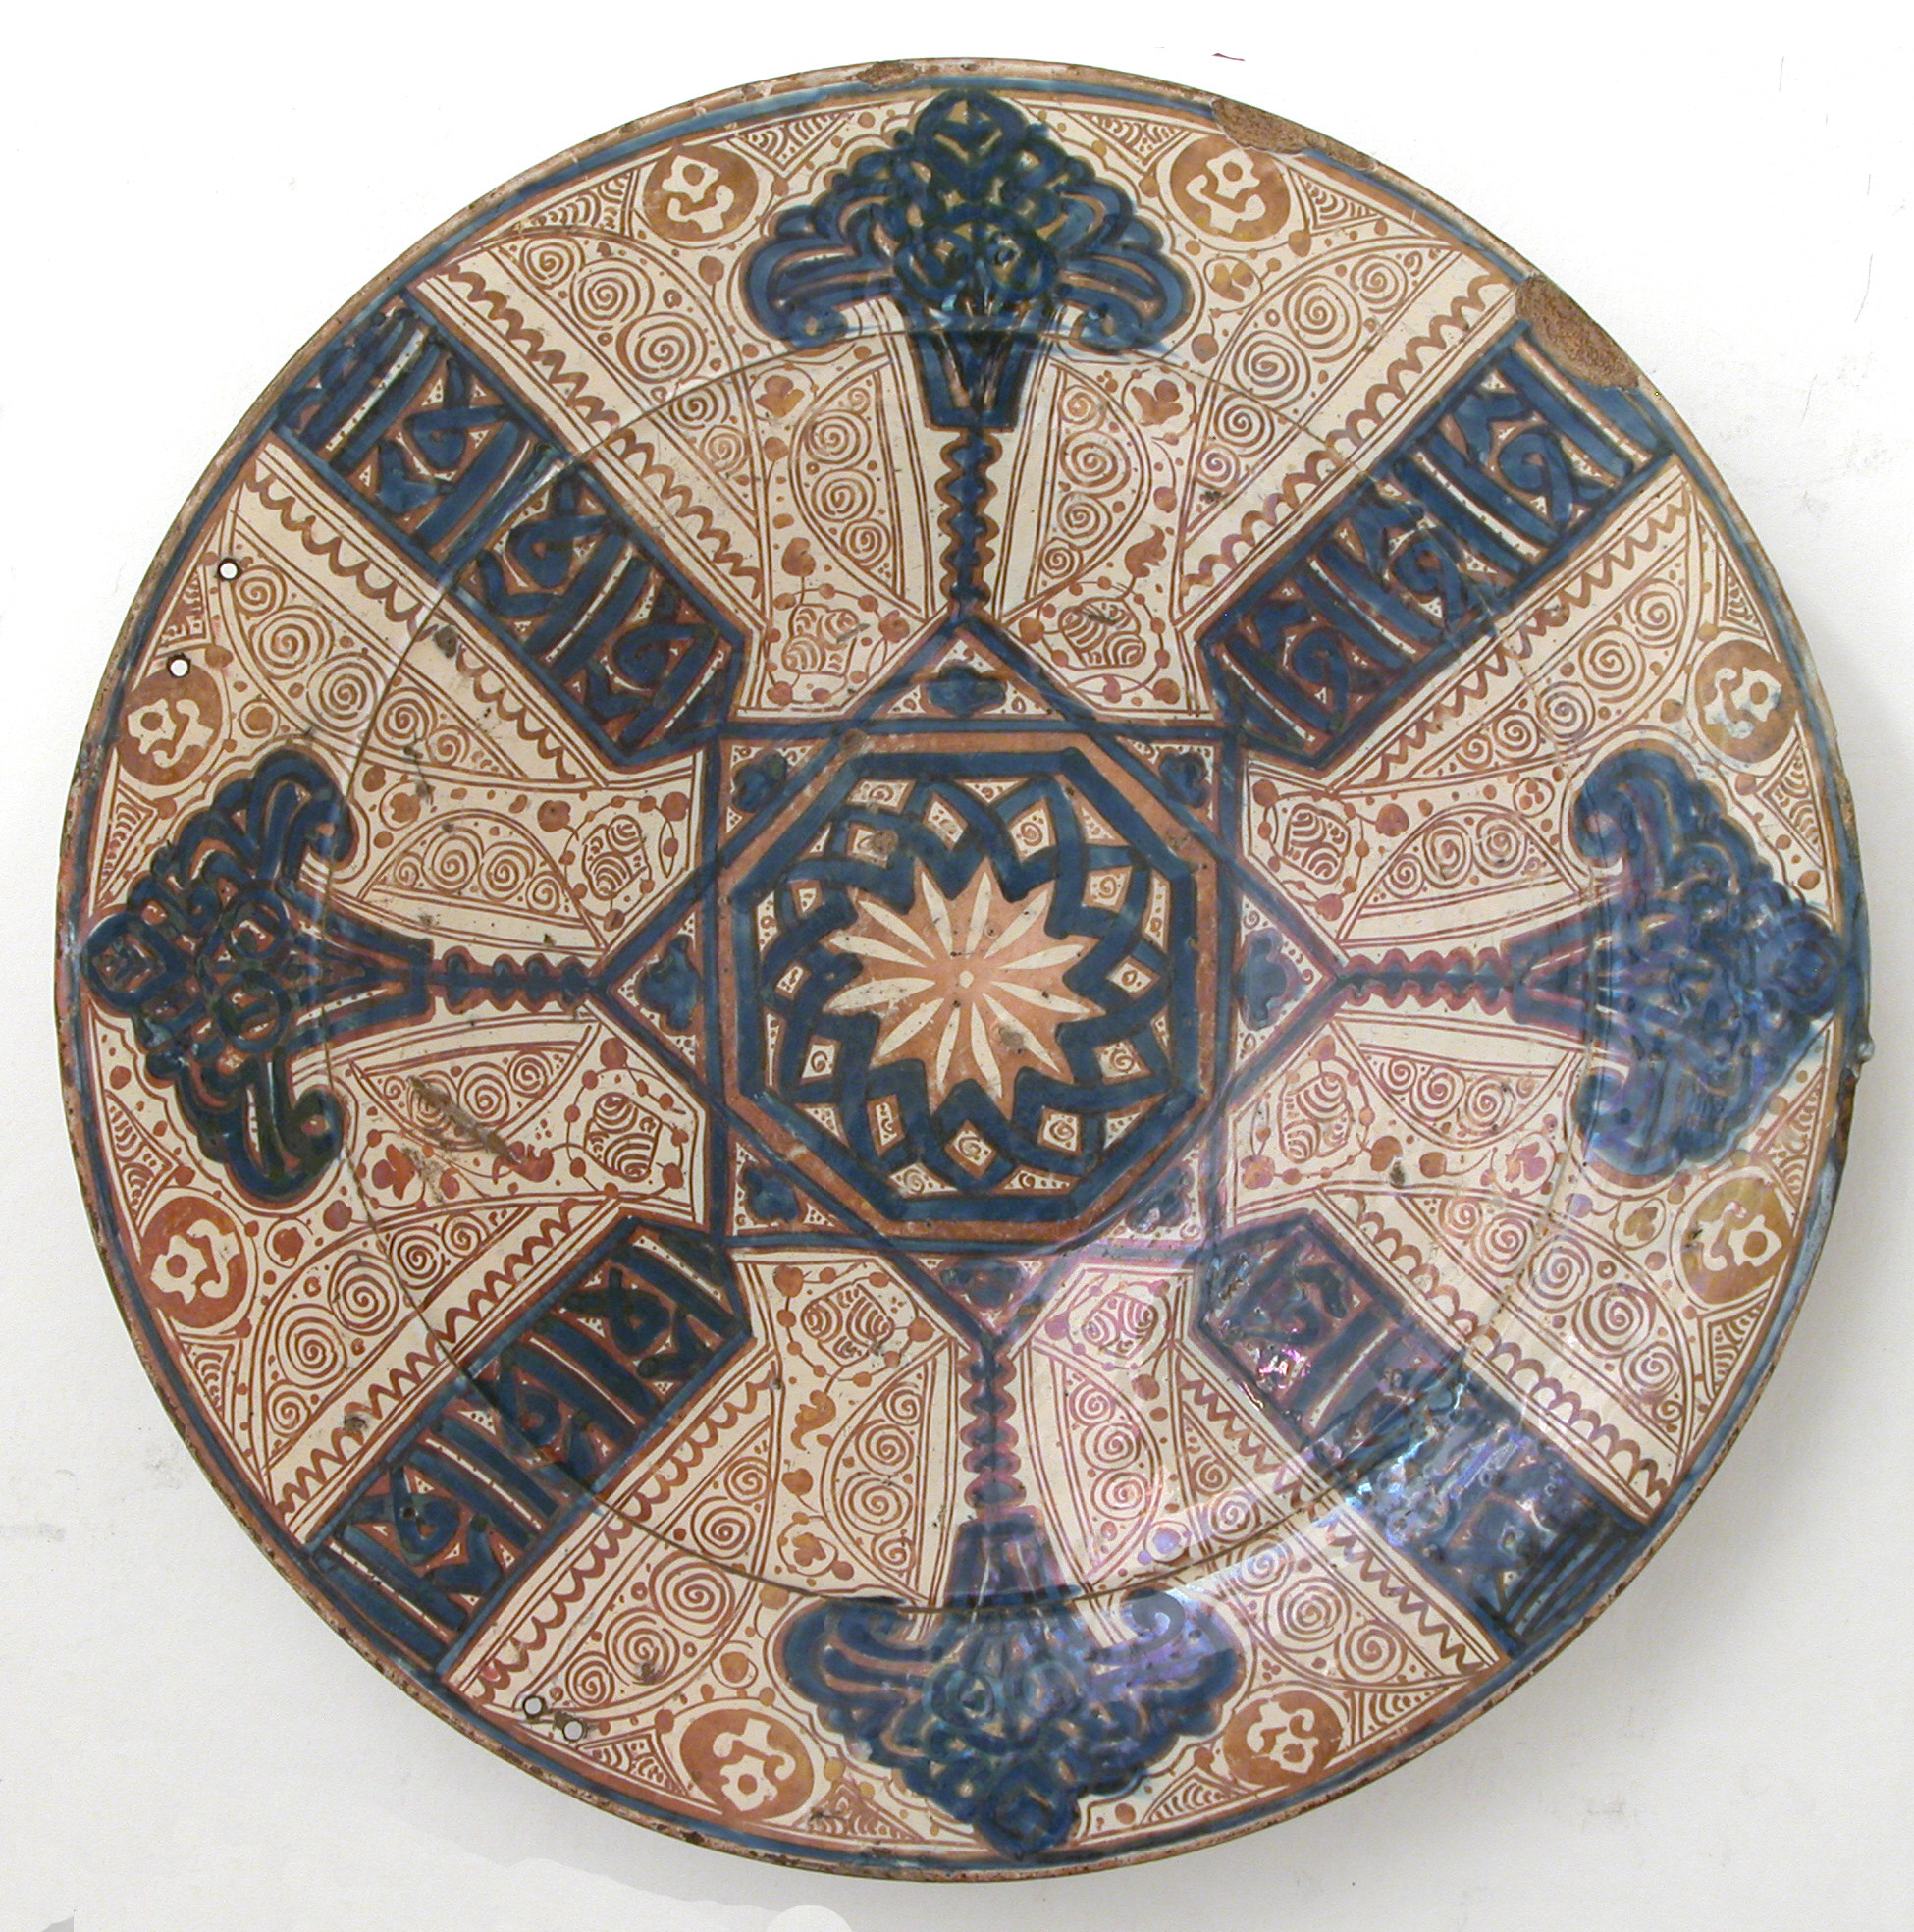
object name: plate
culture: spanish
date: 1367-1433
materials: earthenware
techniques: glazing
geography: spain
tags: eagles